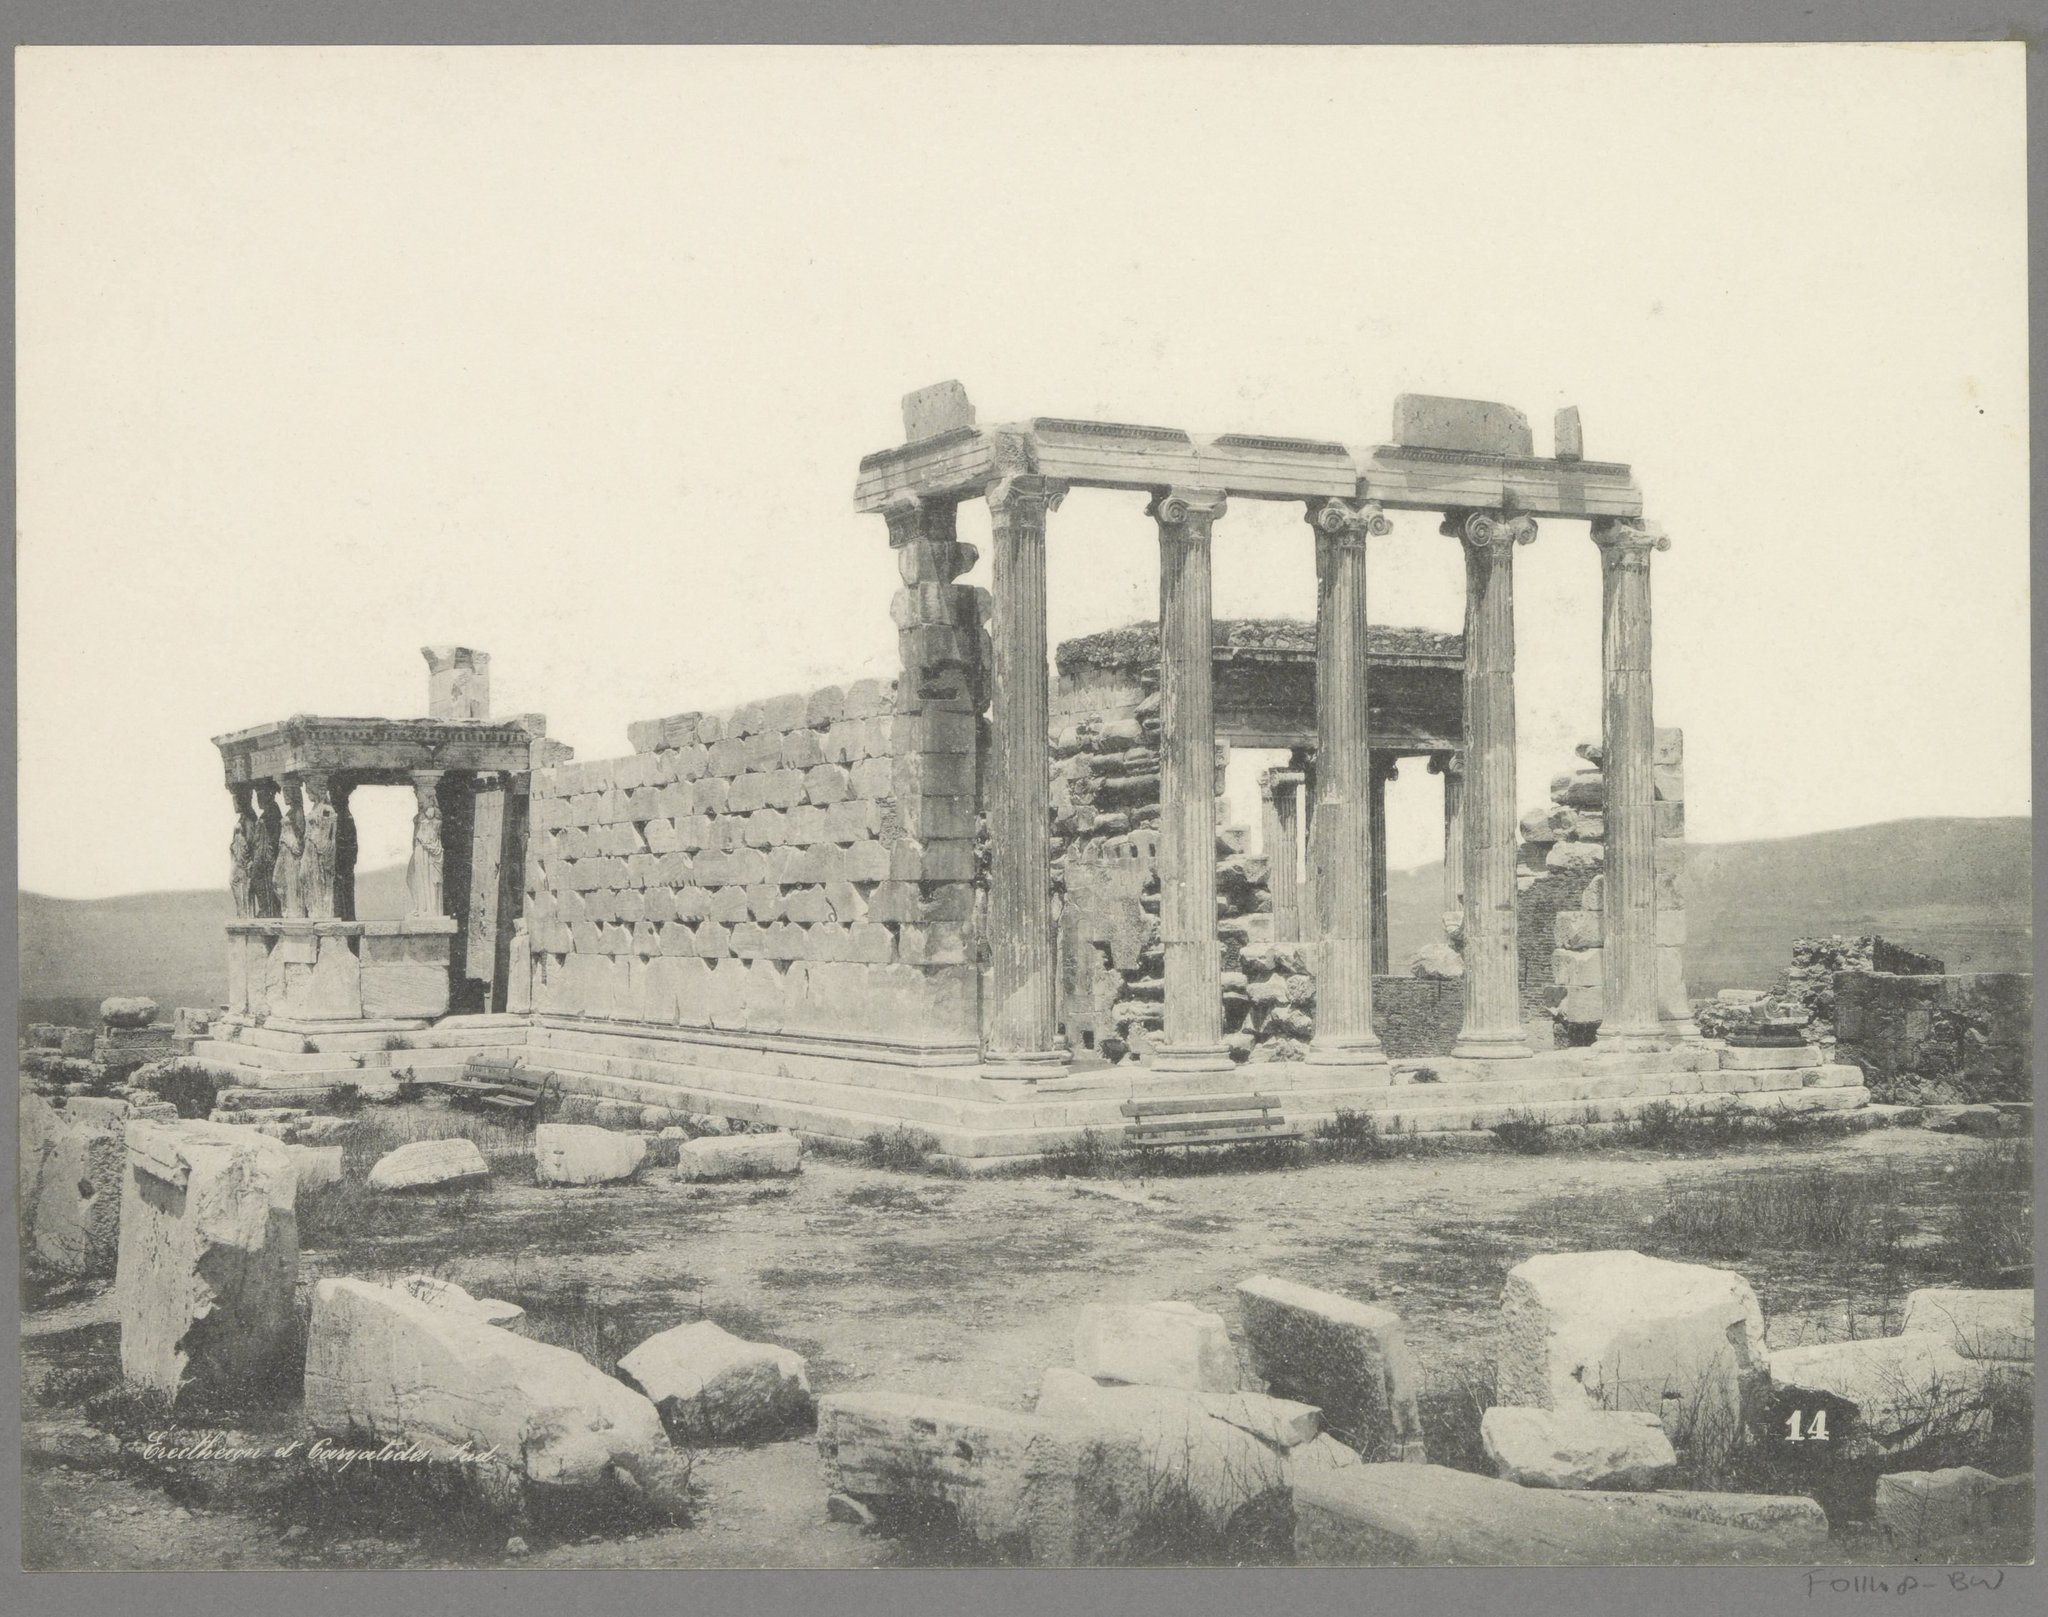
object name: photograph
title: Érectheion et Caryatides, Sud.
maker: Anonymous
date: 1895-1905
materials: paper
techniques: photograph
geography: acropolis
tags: caryatids ~ architecture, temple, shrine ~ greek religion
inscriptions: number: ‘14’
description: Onderdeel van Reisalbum met foto's van bezienswaardigheden in Griekenland en Egypte.